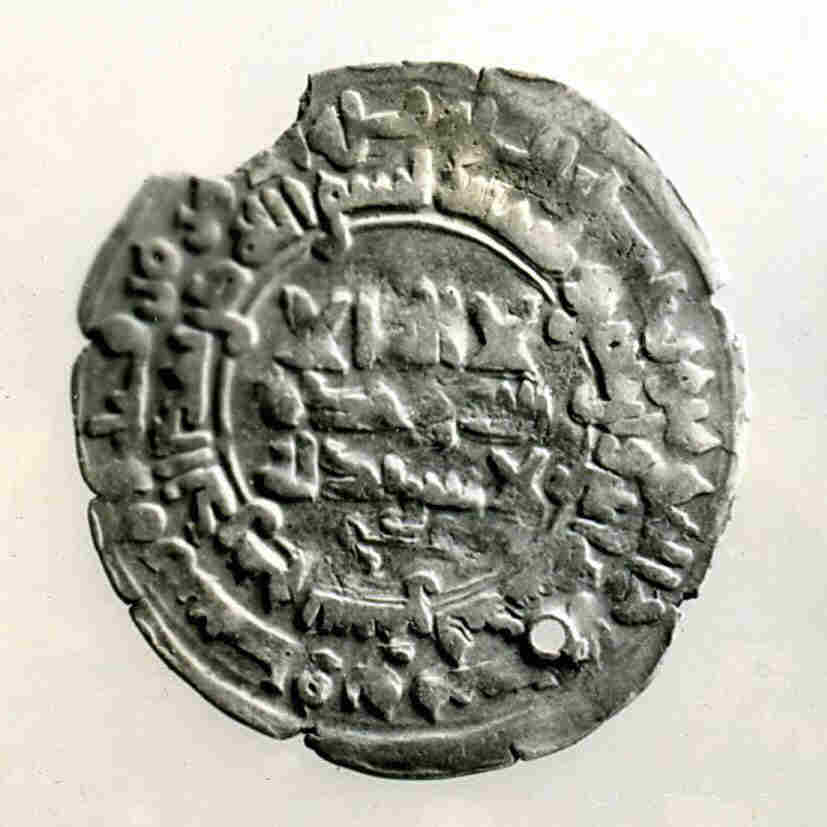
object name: coin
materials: silver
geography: uzbekistan